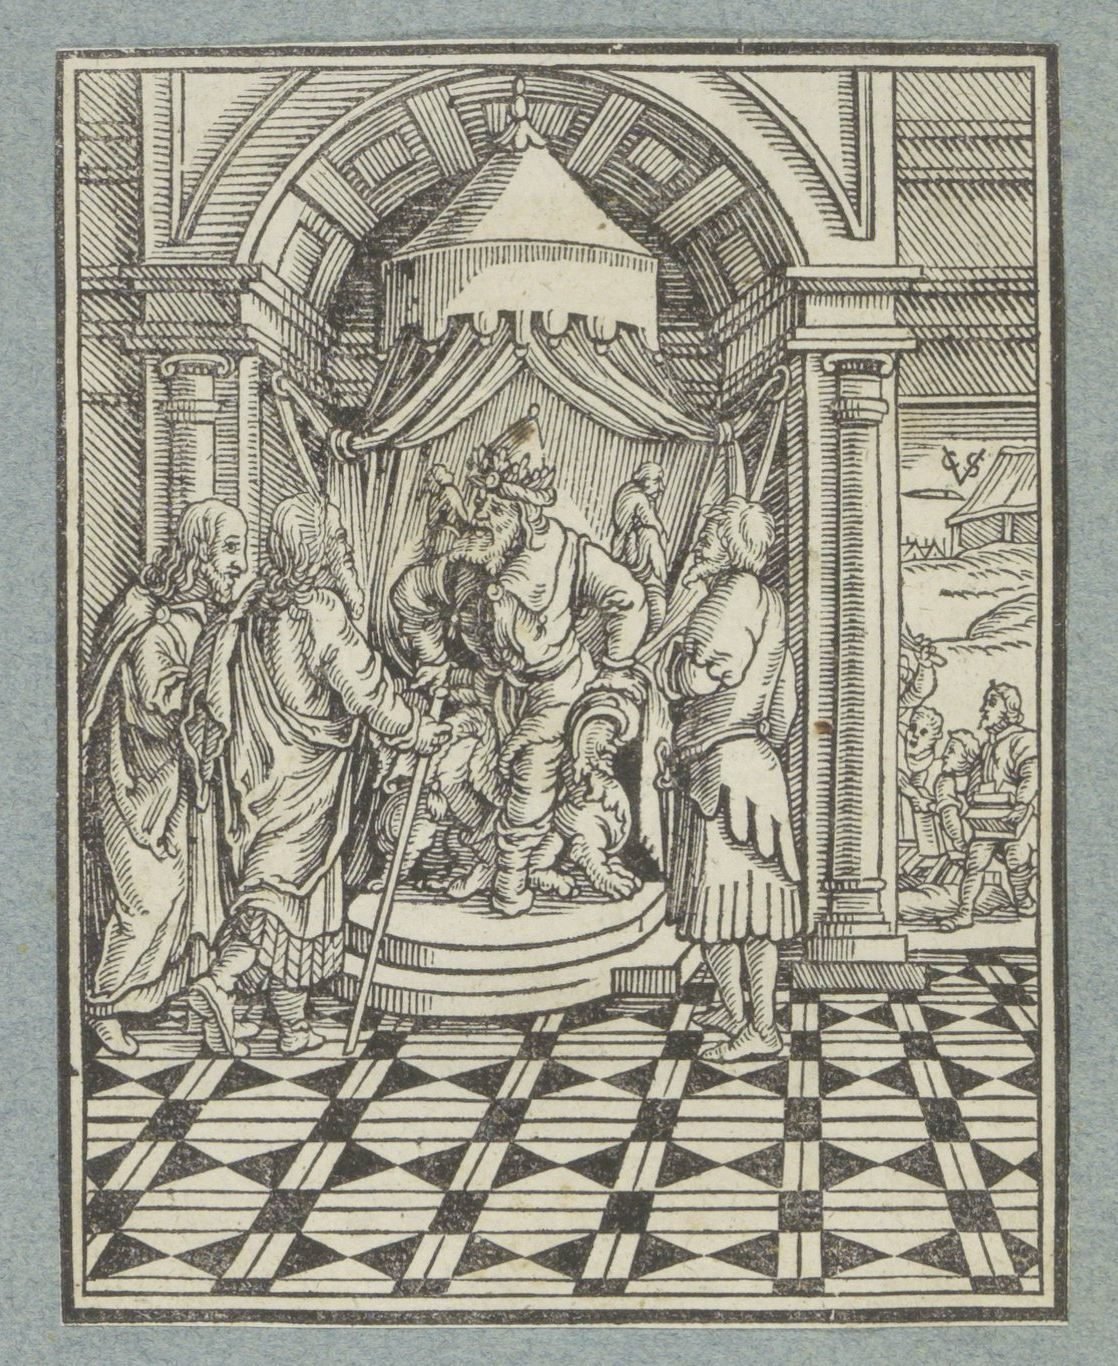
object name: book illustration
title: Mozes en Aäron voor de farao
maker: pieter jacobsz. paets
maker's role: publisher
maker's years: 1587-1667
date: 1645-1646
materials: paper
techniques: letterpress printing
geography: amsterdam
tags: moses and aaron confront pharaoh (exodus 5-7:13)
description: De prent werd gemaakt voor de uitgaven van P.J. Paets uit Amsterdam. Ze komt in ieder geval voor in: Bibels Tresoor ofte der zielen lusthof. Amsterdam, P.J. Paets, 1646. Mogelijk ook in: Historien ende Prophetien. [Amsterdam], P.J. Paets, 1645.